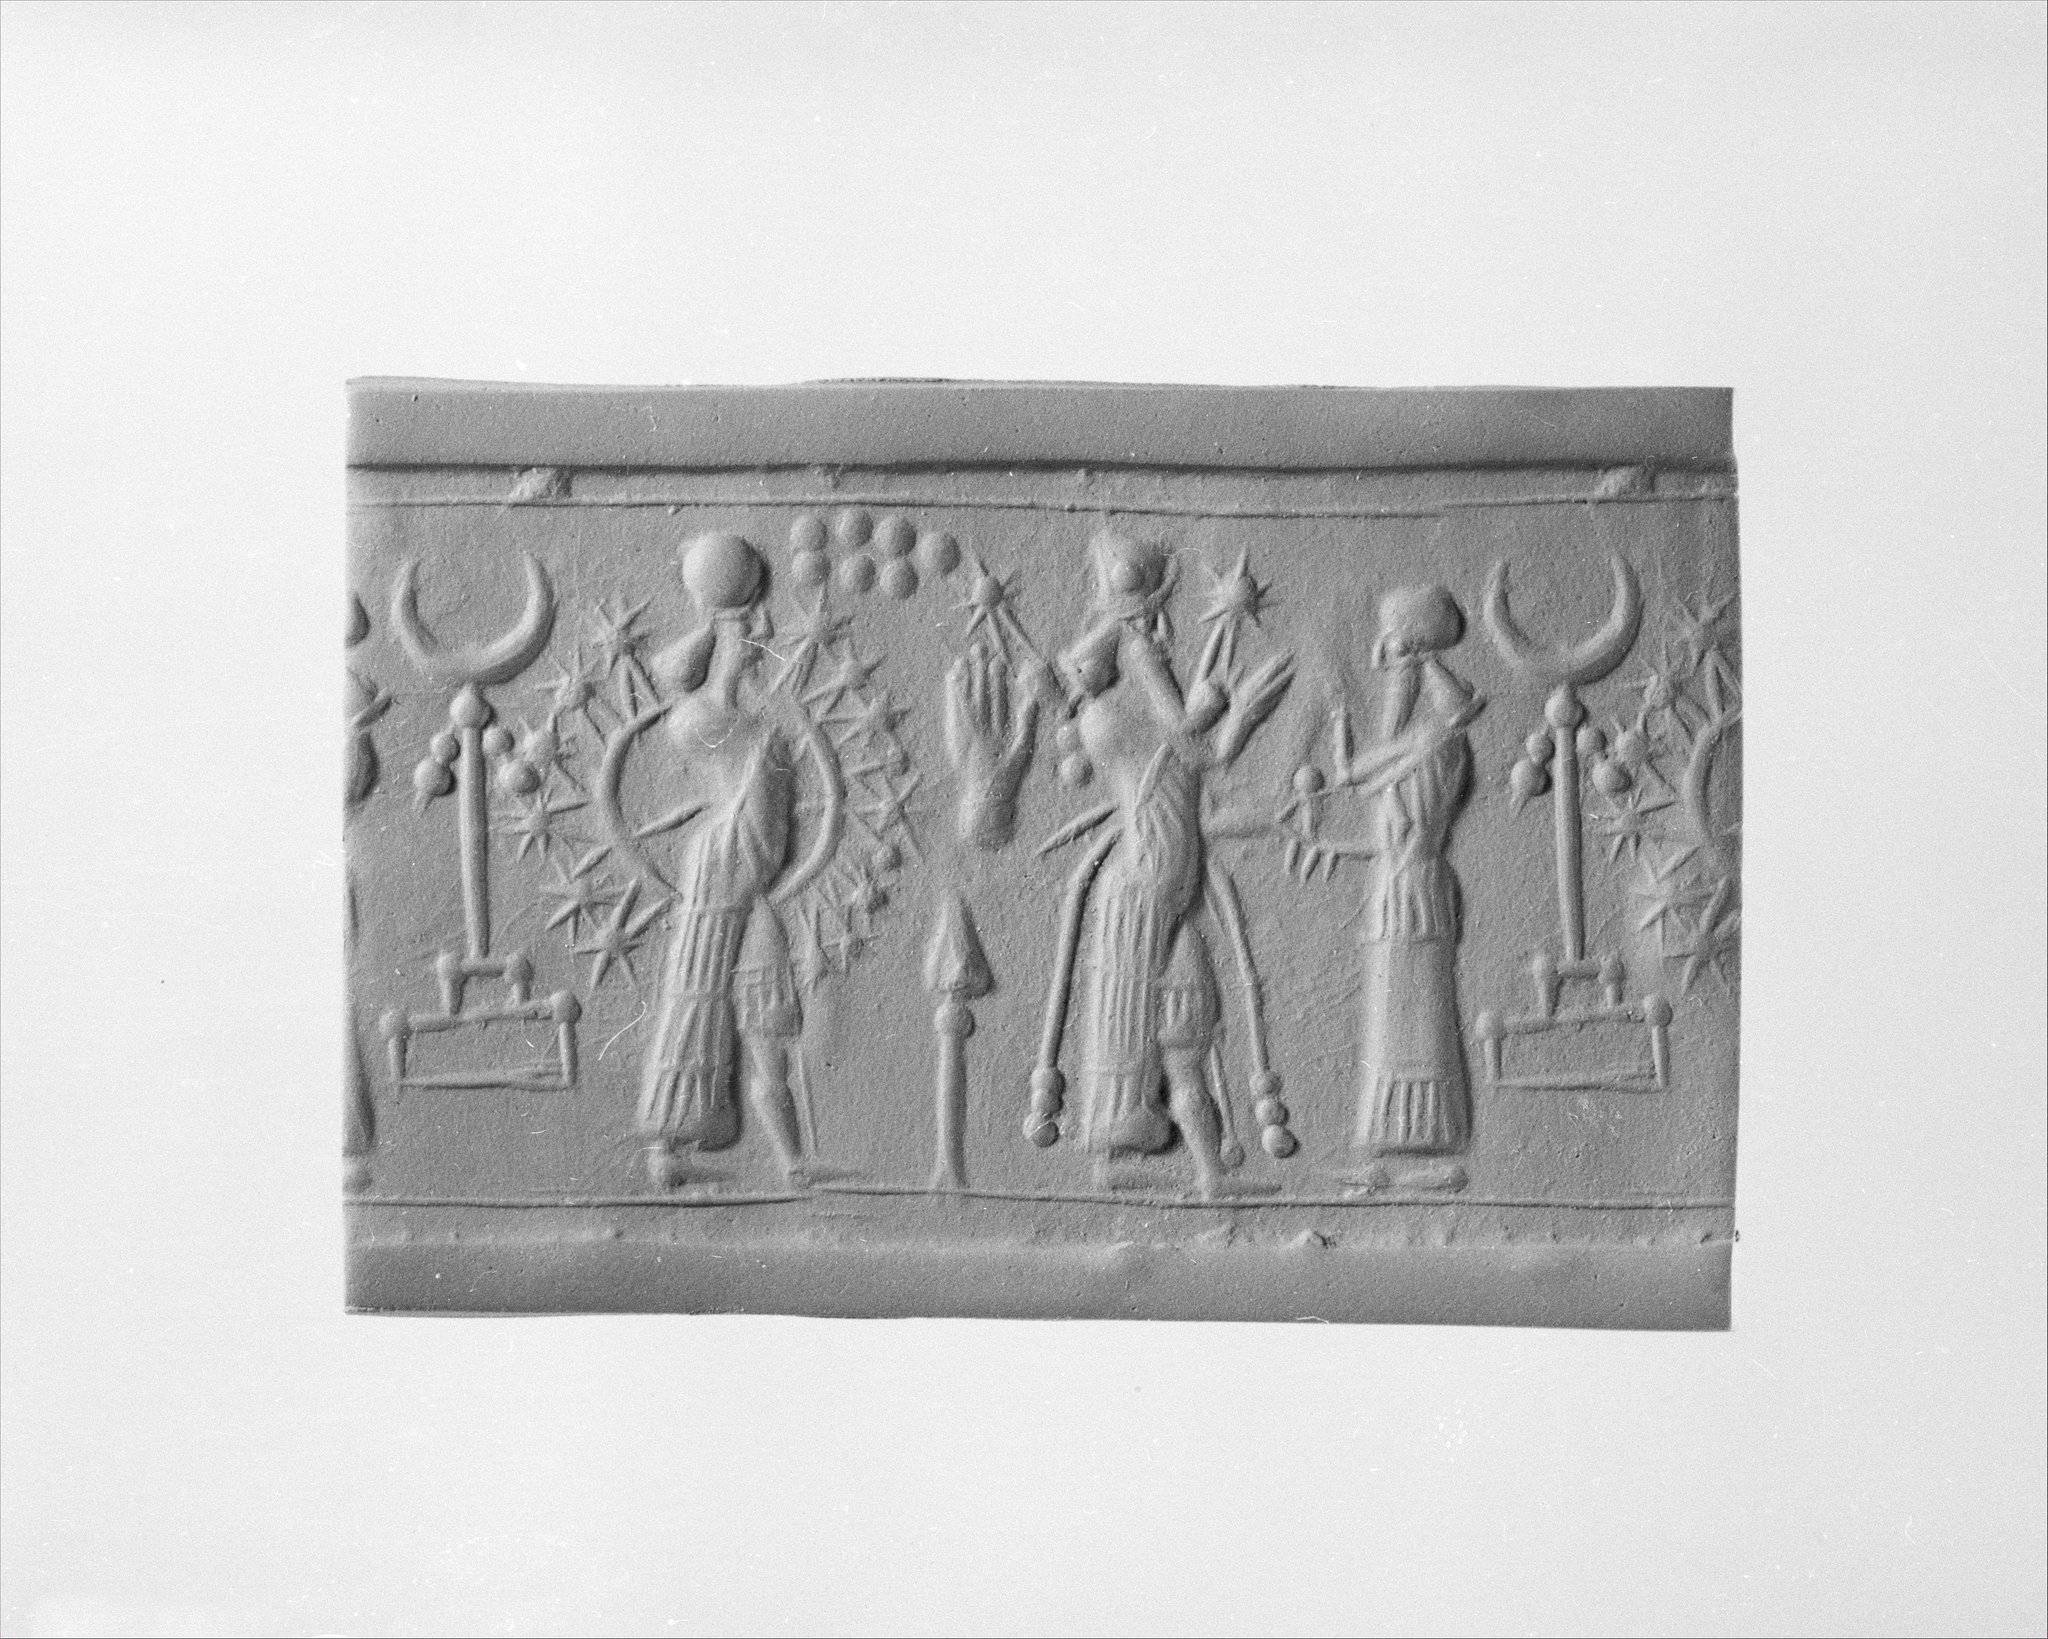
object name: stamp cylinder seal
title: Stamp-cylinder seal with cultic scene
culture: assyro-babylonian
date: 800-701 BCE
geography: mesopotamia